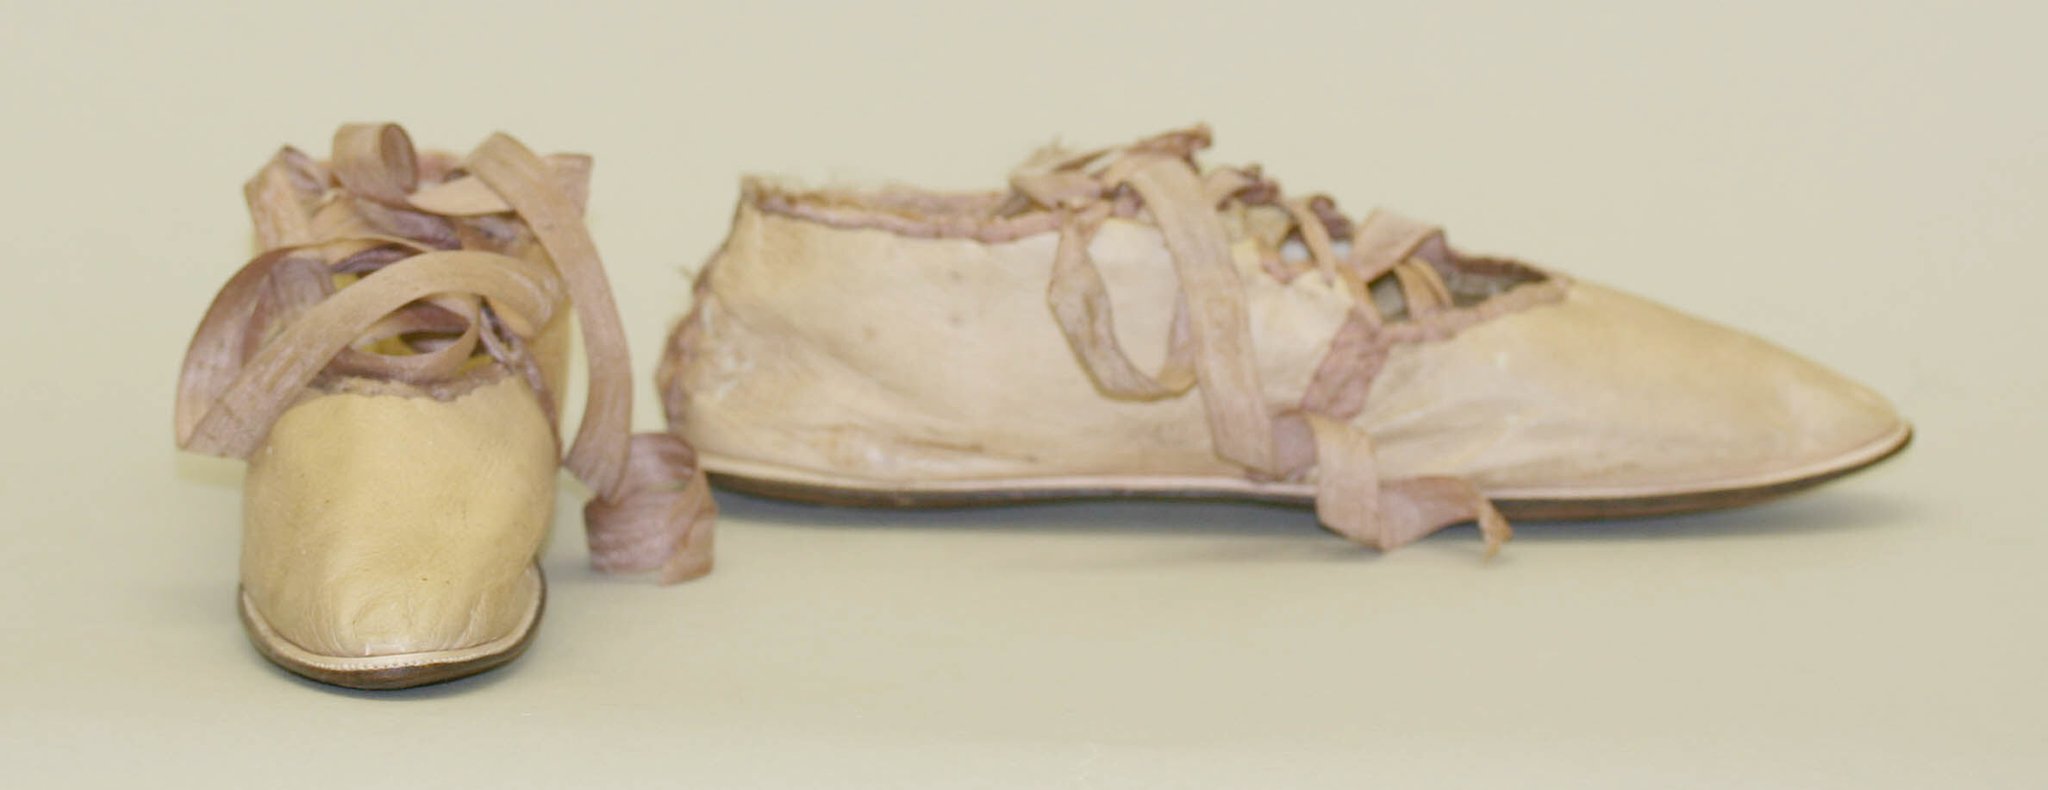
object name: slipper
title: Slippers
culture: european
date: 1834-1866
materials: leather, silk